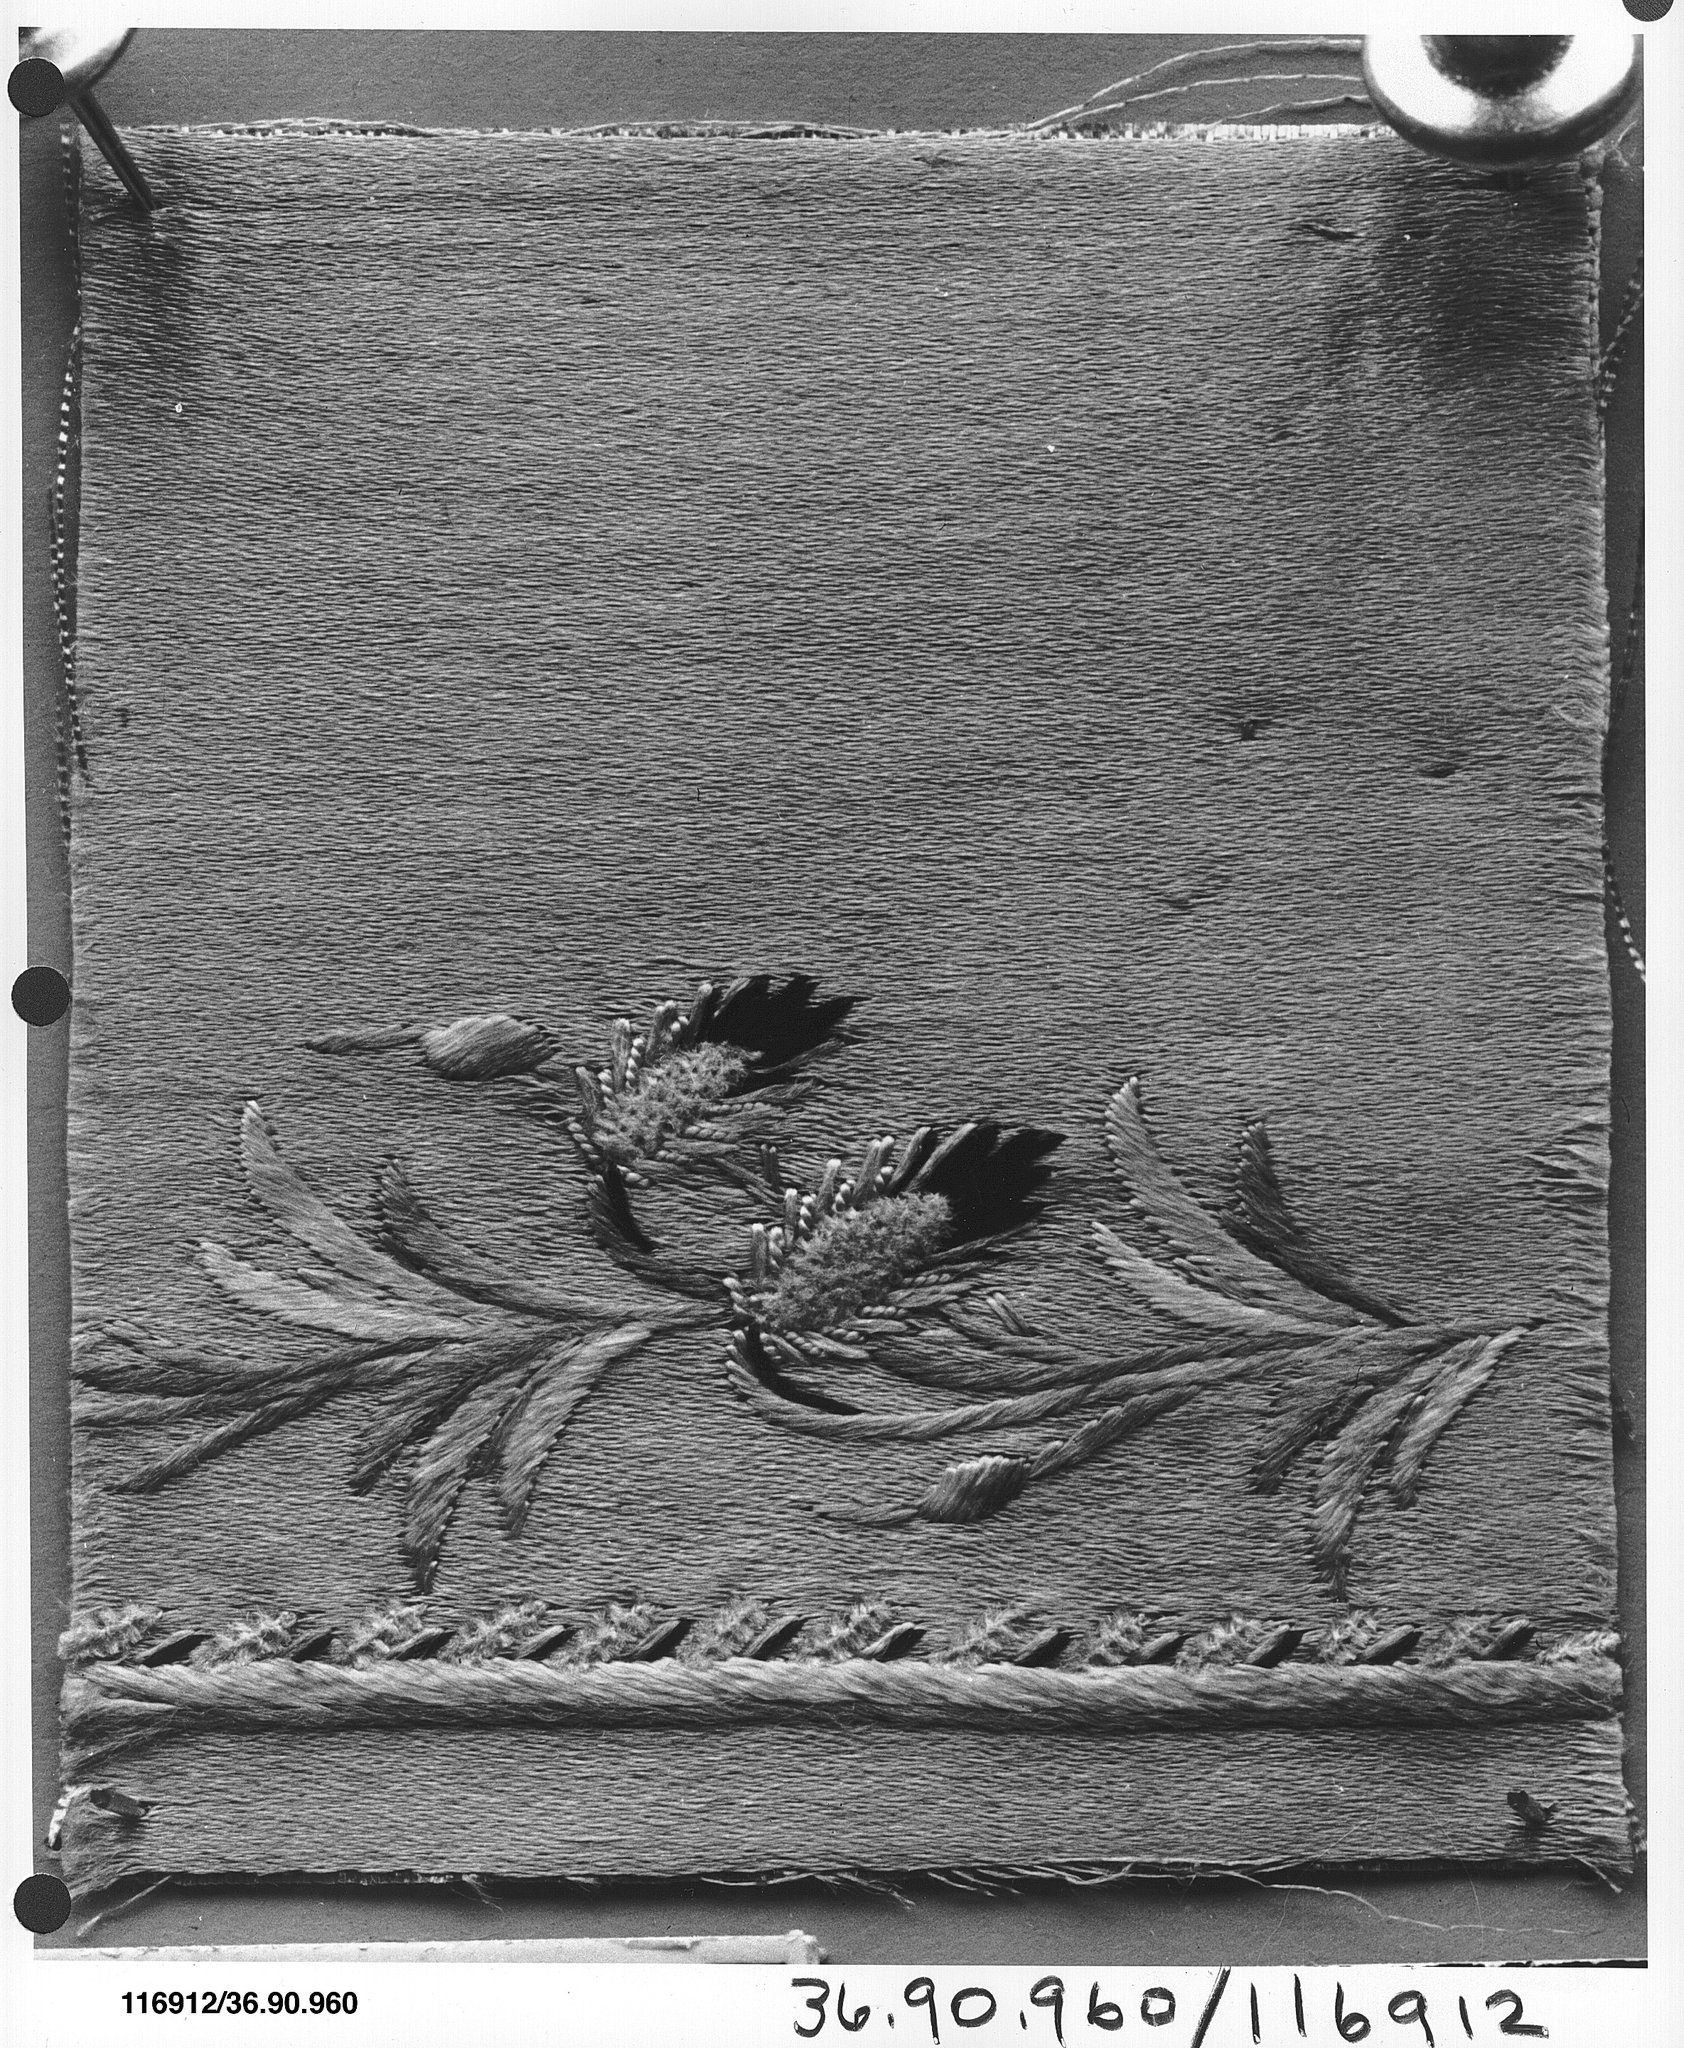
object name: sample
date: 1801-1833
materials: silk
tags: flowers